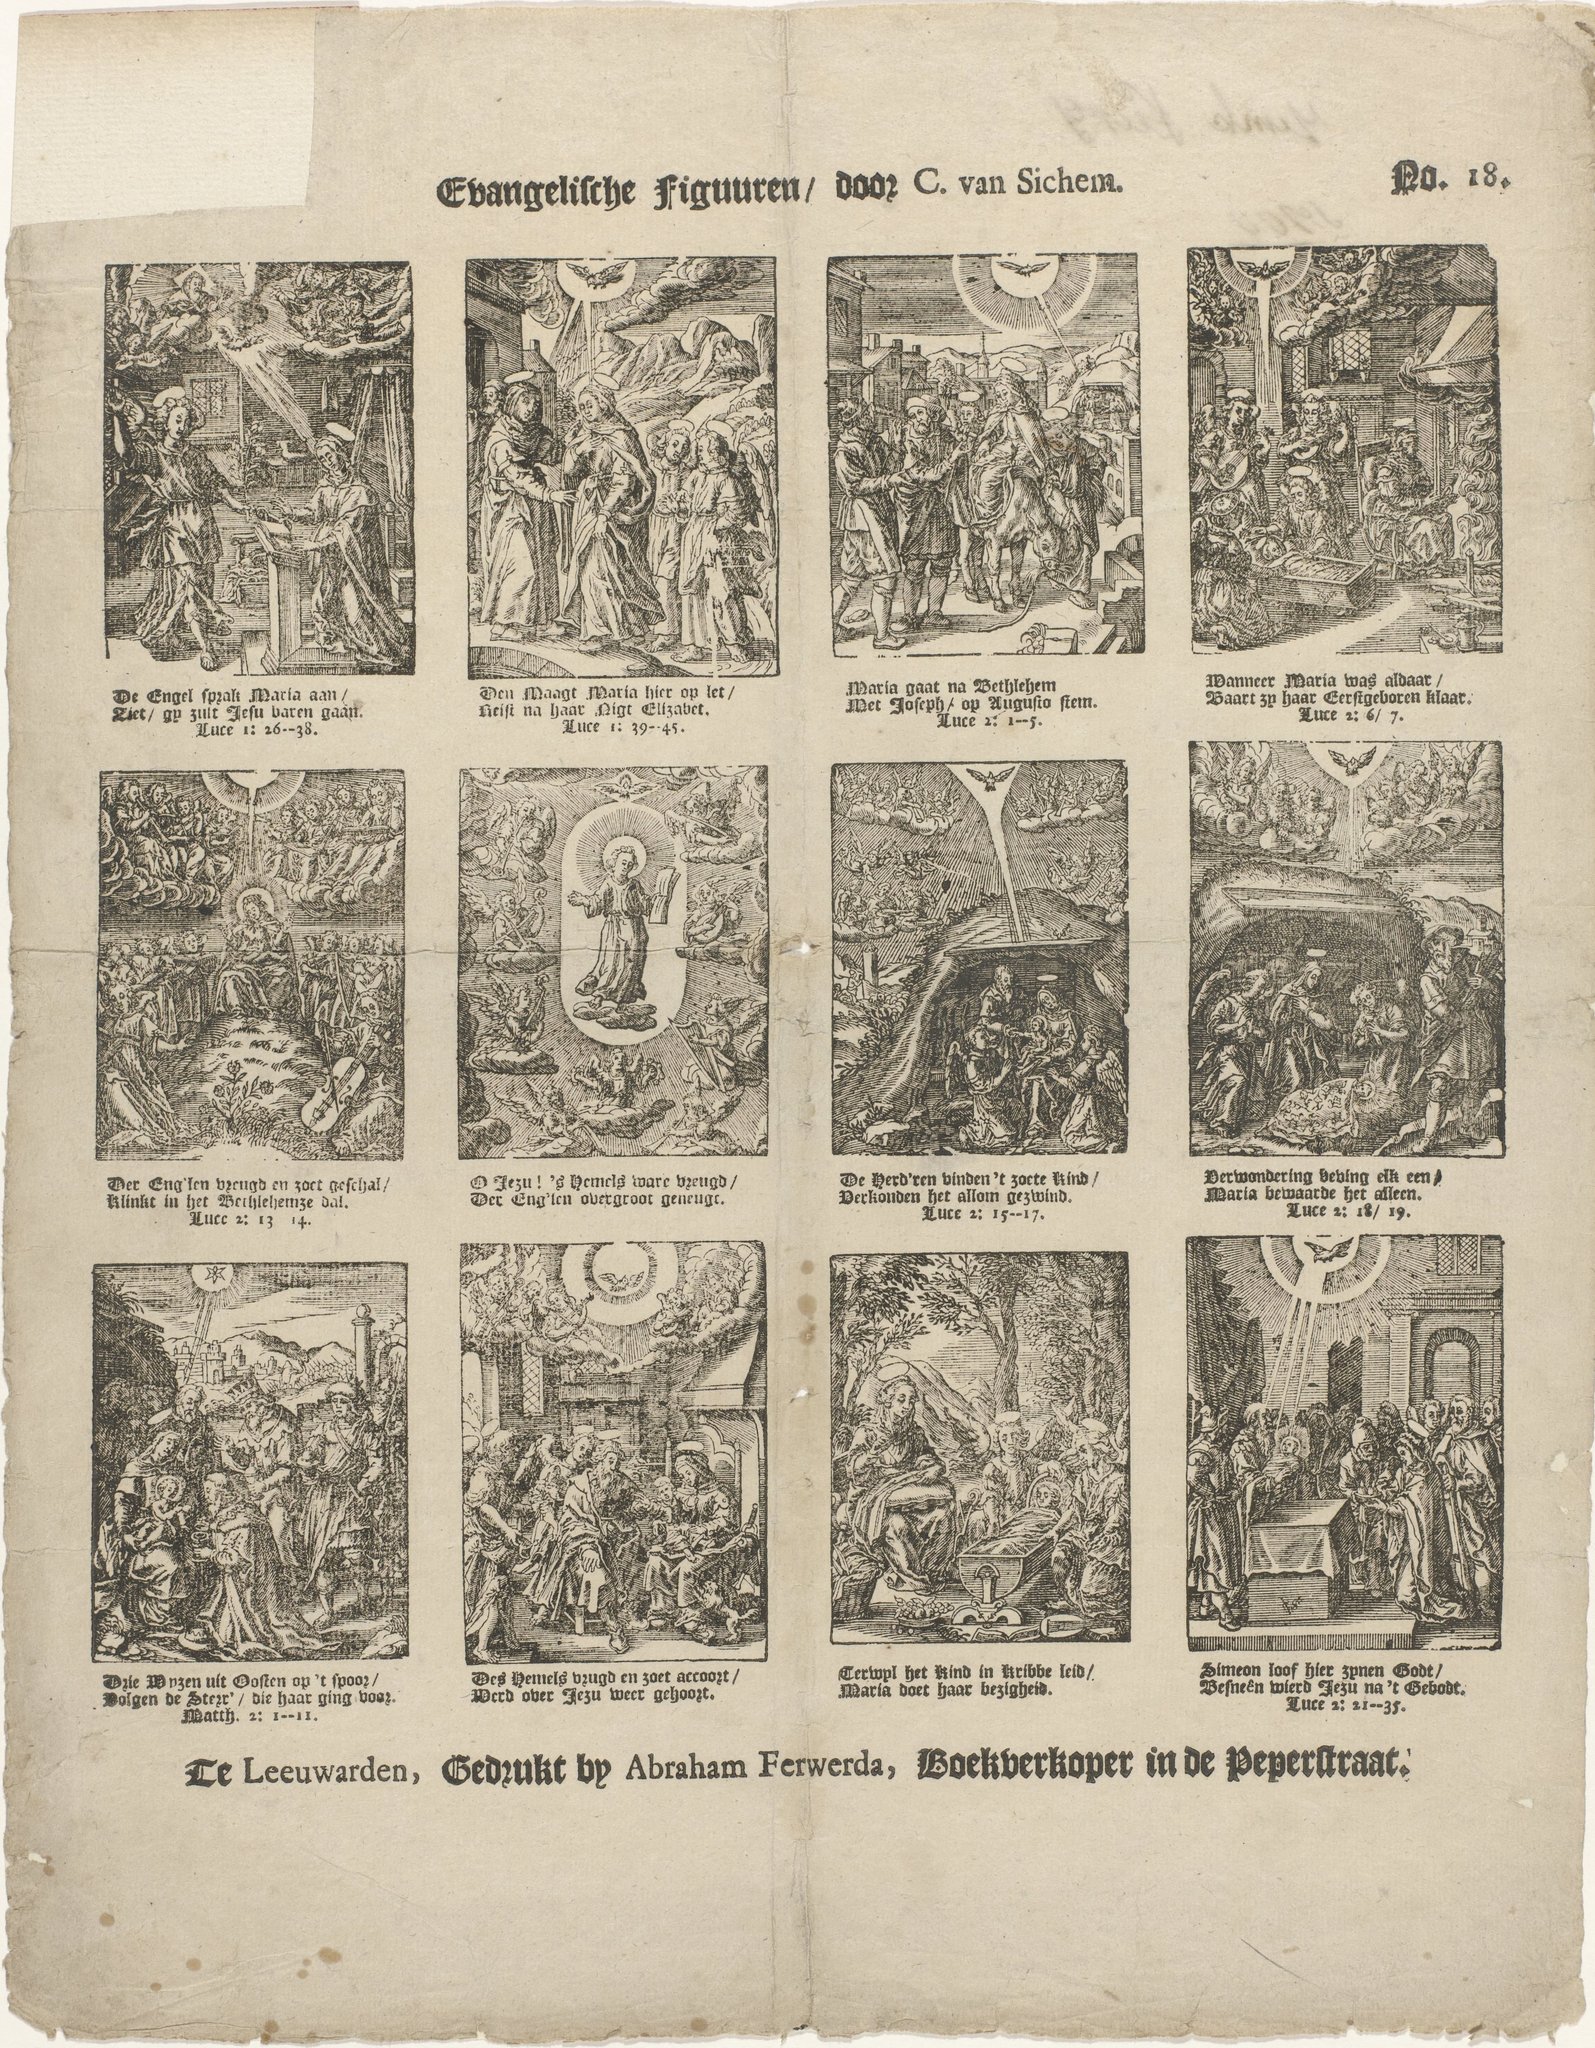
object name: print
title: Evangelische figuuren / door C. van Sichem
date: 1769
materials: paper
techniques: letterpress printing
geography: leeuwarden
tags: new testament, series of scenes from the life of christ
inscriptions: collector's mark: Lugt 2760, collector's mark: Lugt 2228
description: Blad met 12 voorstellingen uit het Nieuwe Testament, waaronder de Annunciatie, de aanbidding door de herders en de aanbidding door de koningen. Onder elke voorstelling een tweeregelig vers en soms het bijbehorende bijbelcitaat. Genummerd rechtsboven: No. 18.